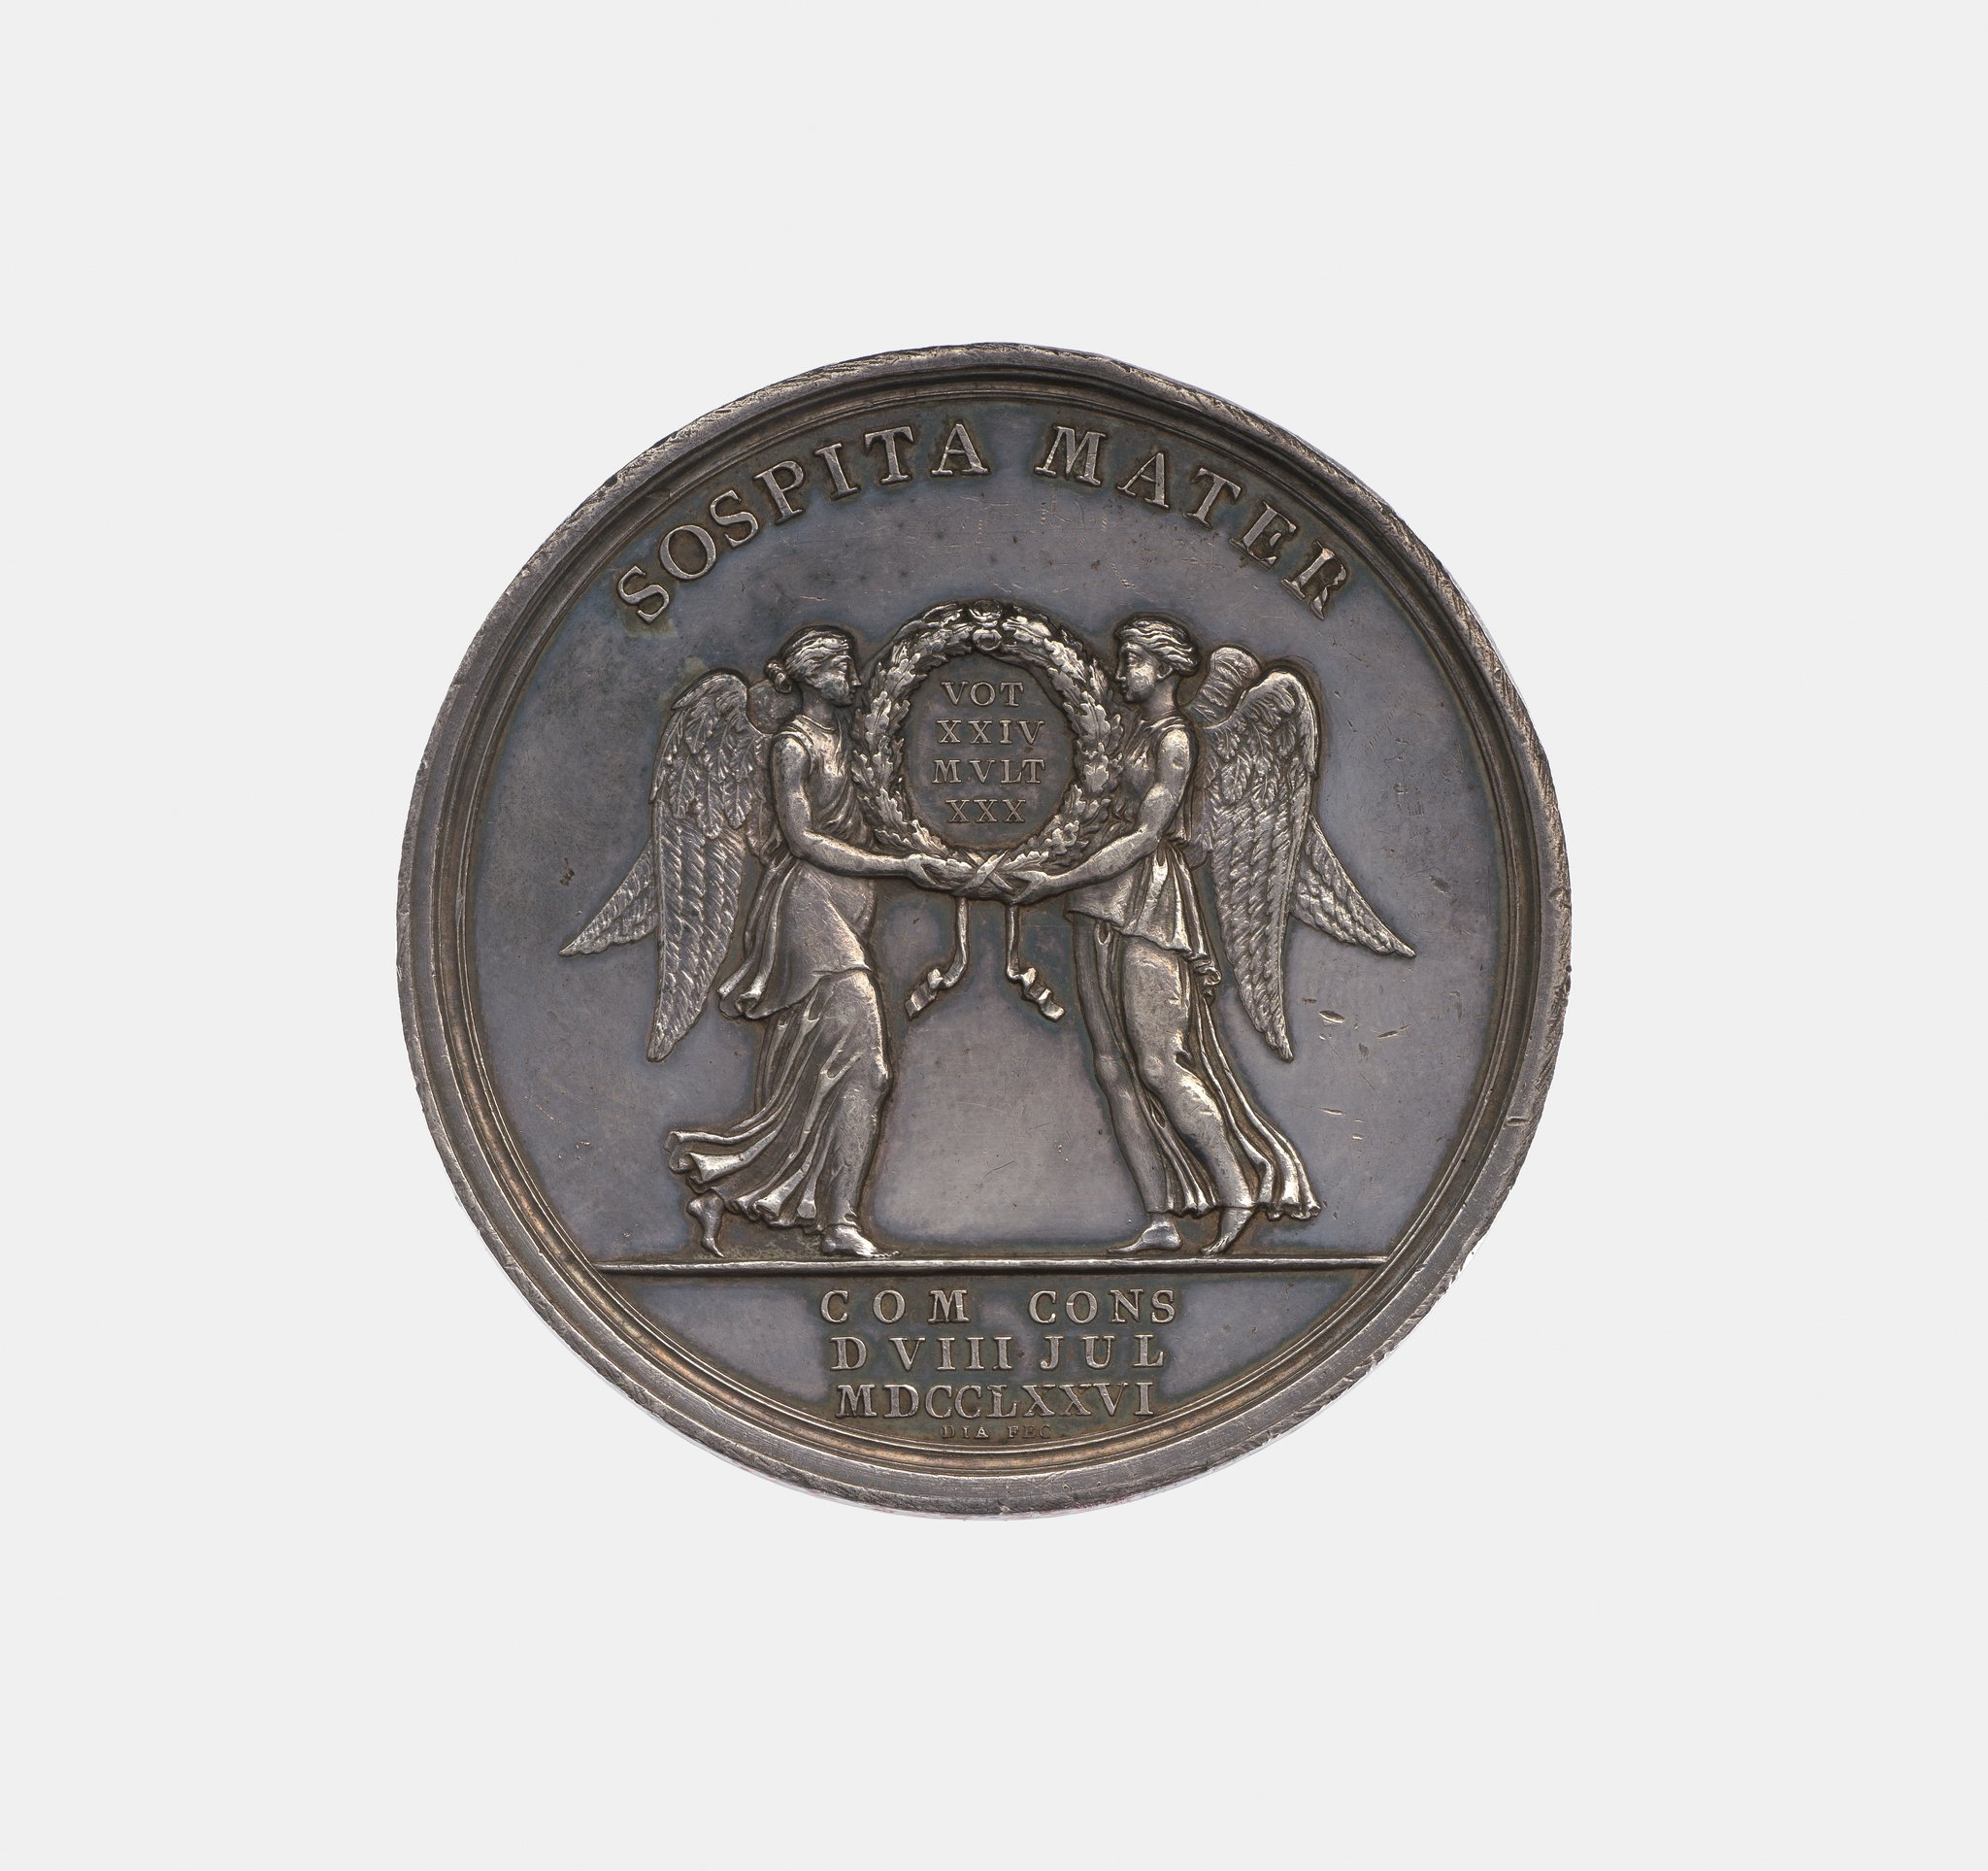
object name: medal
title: 24th Wedding Anniversary of Juliana Maria to king Frederick V of Denmark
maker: daniel jensen adzer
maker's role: artist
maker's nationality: danish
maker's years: 1708-1808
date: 1776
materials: silver